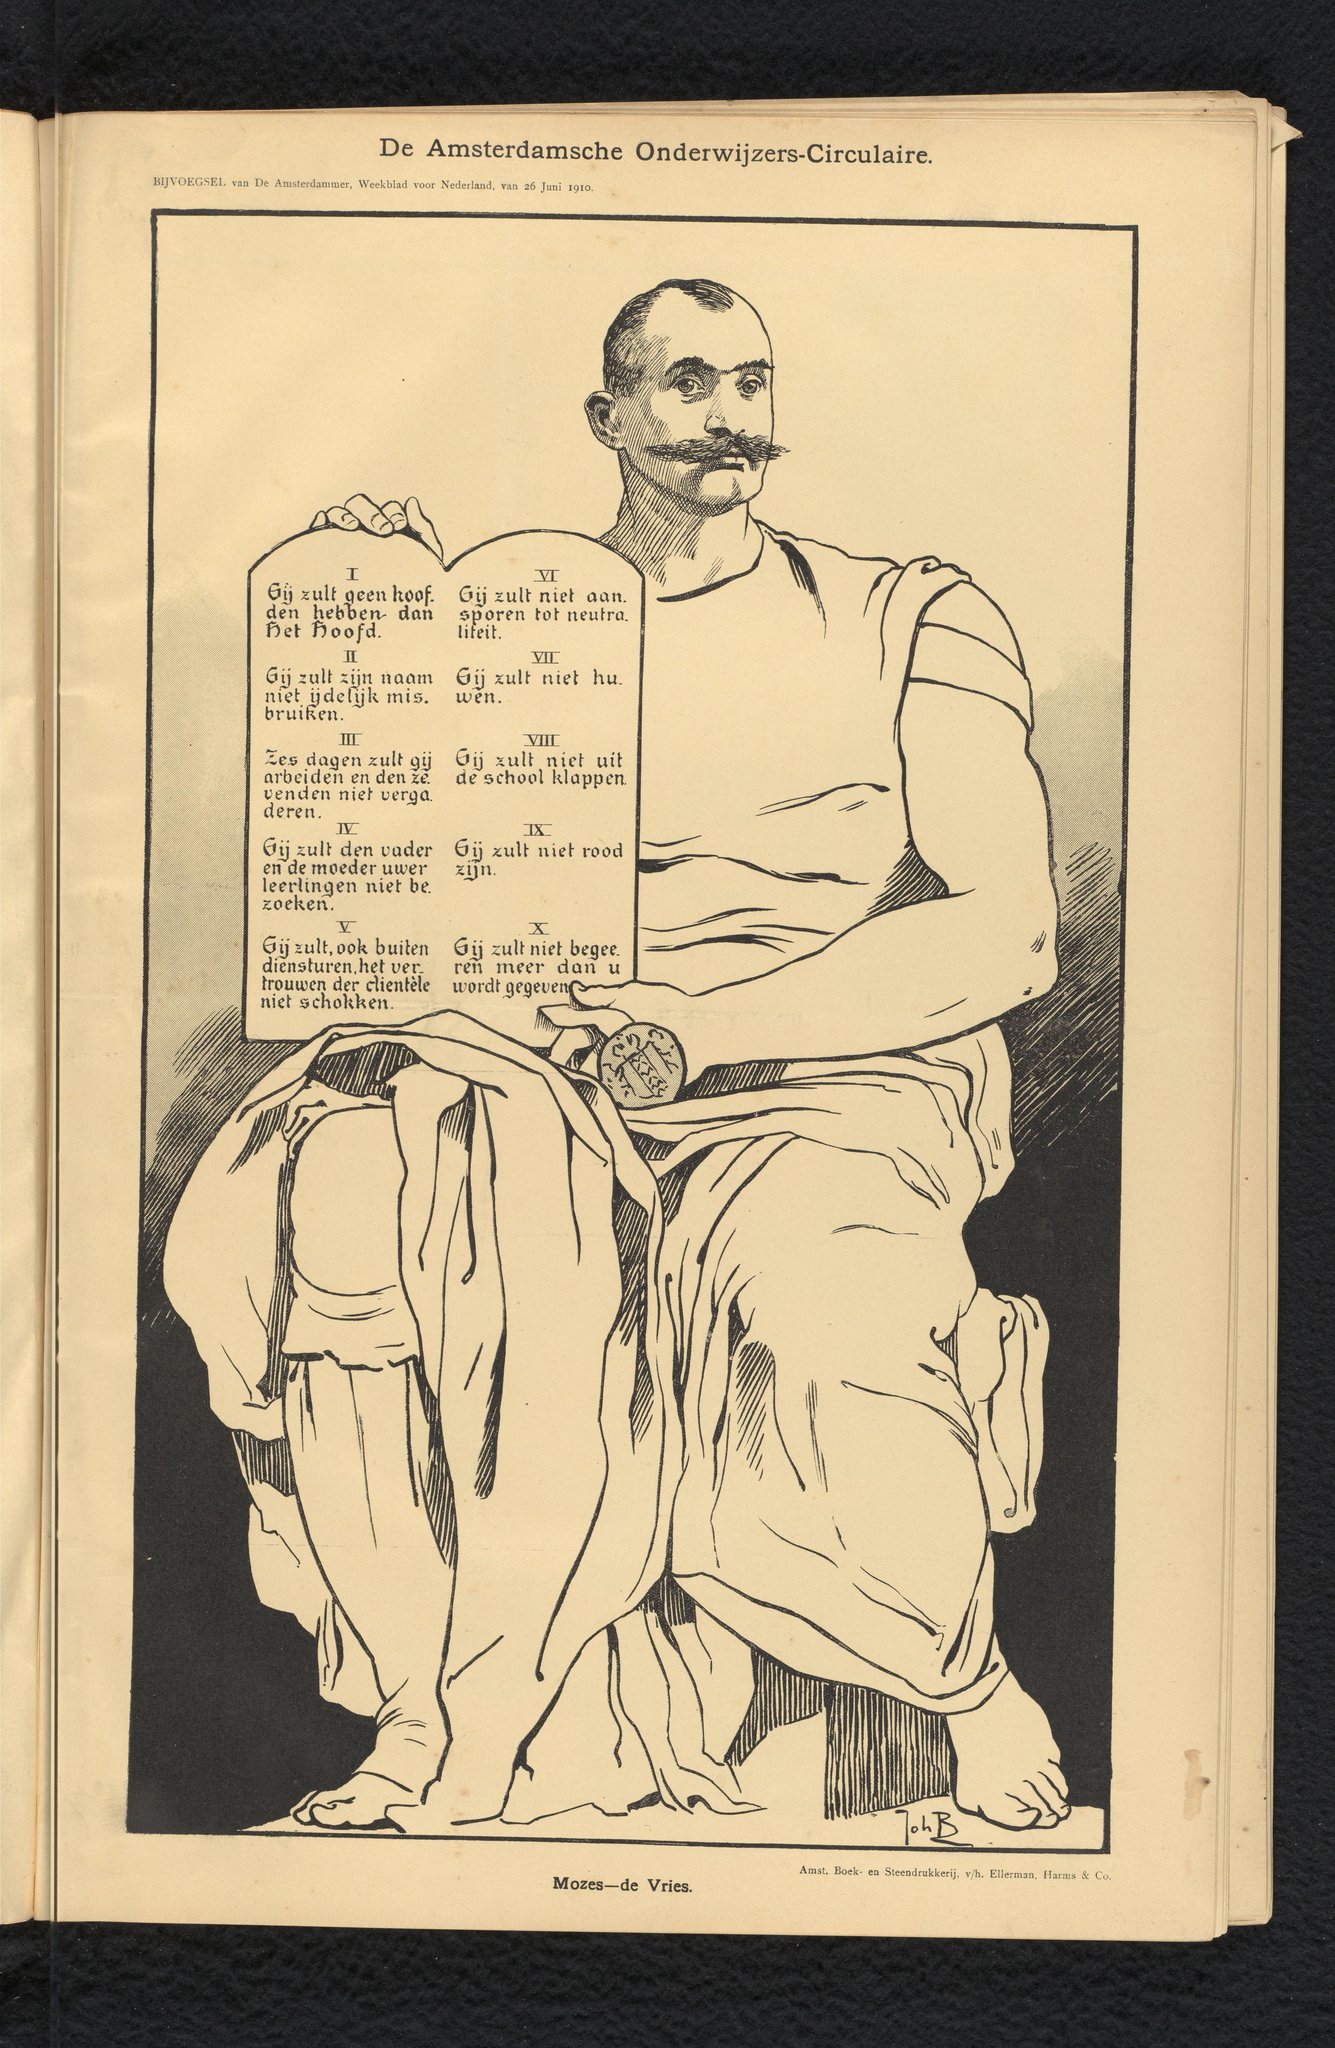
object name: cartoon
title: De Amsterdaamsche Onderwijzers-Circulaire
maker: johan braakensiek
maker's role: draughtsman, print maker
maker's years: 1858-1940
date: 1910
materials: paper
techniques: lithograph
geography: amsterdam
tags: moses receives the tables of the law from god, elementary school; class, form, political caricatures and satires, amsterdam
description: De Amsterdamse wethouder Simon de Vries Czn als Mozes met in zijn handen de stenen wetstafelen met tien geboden waar de Amsterdamse onderwijzers zich aan zouden moeten houden.